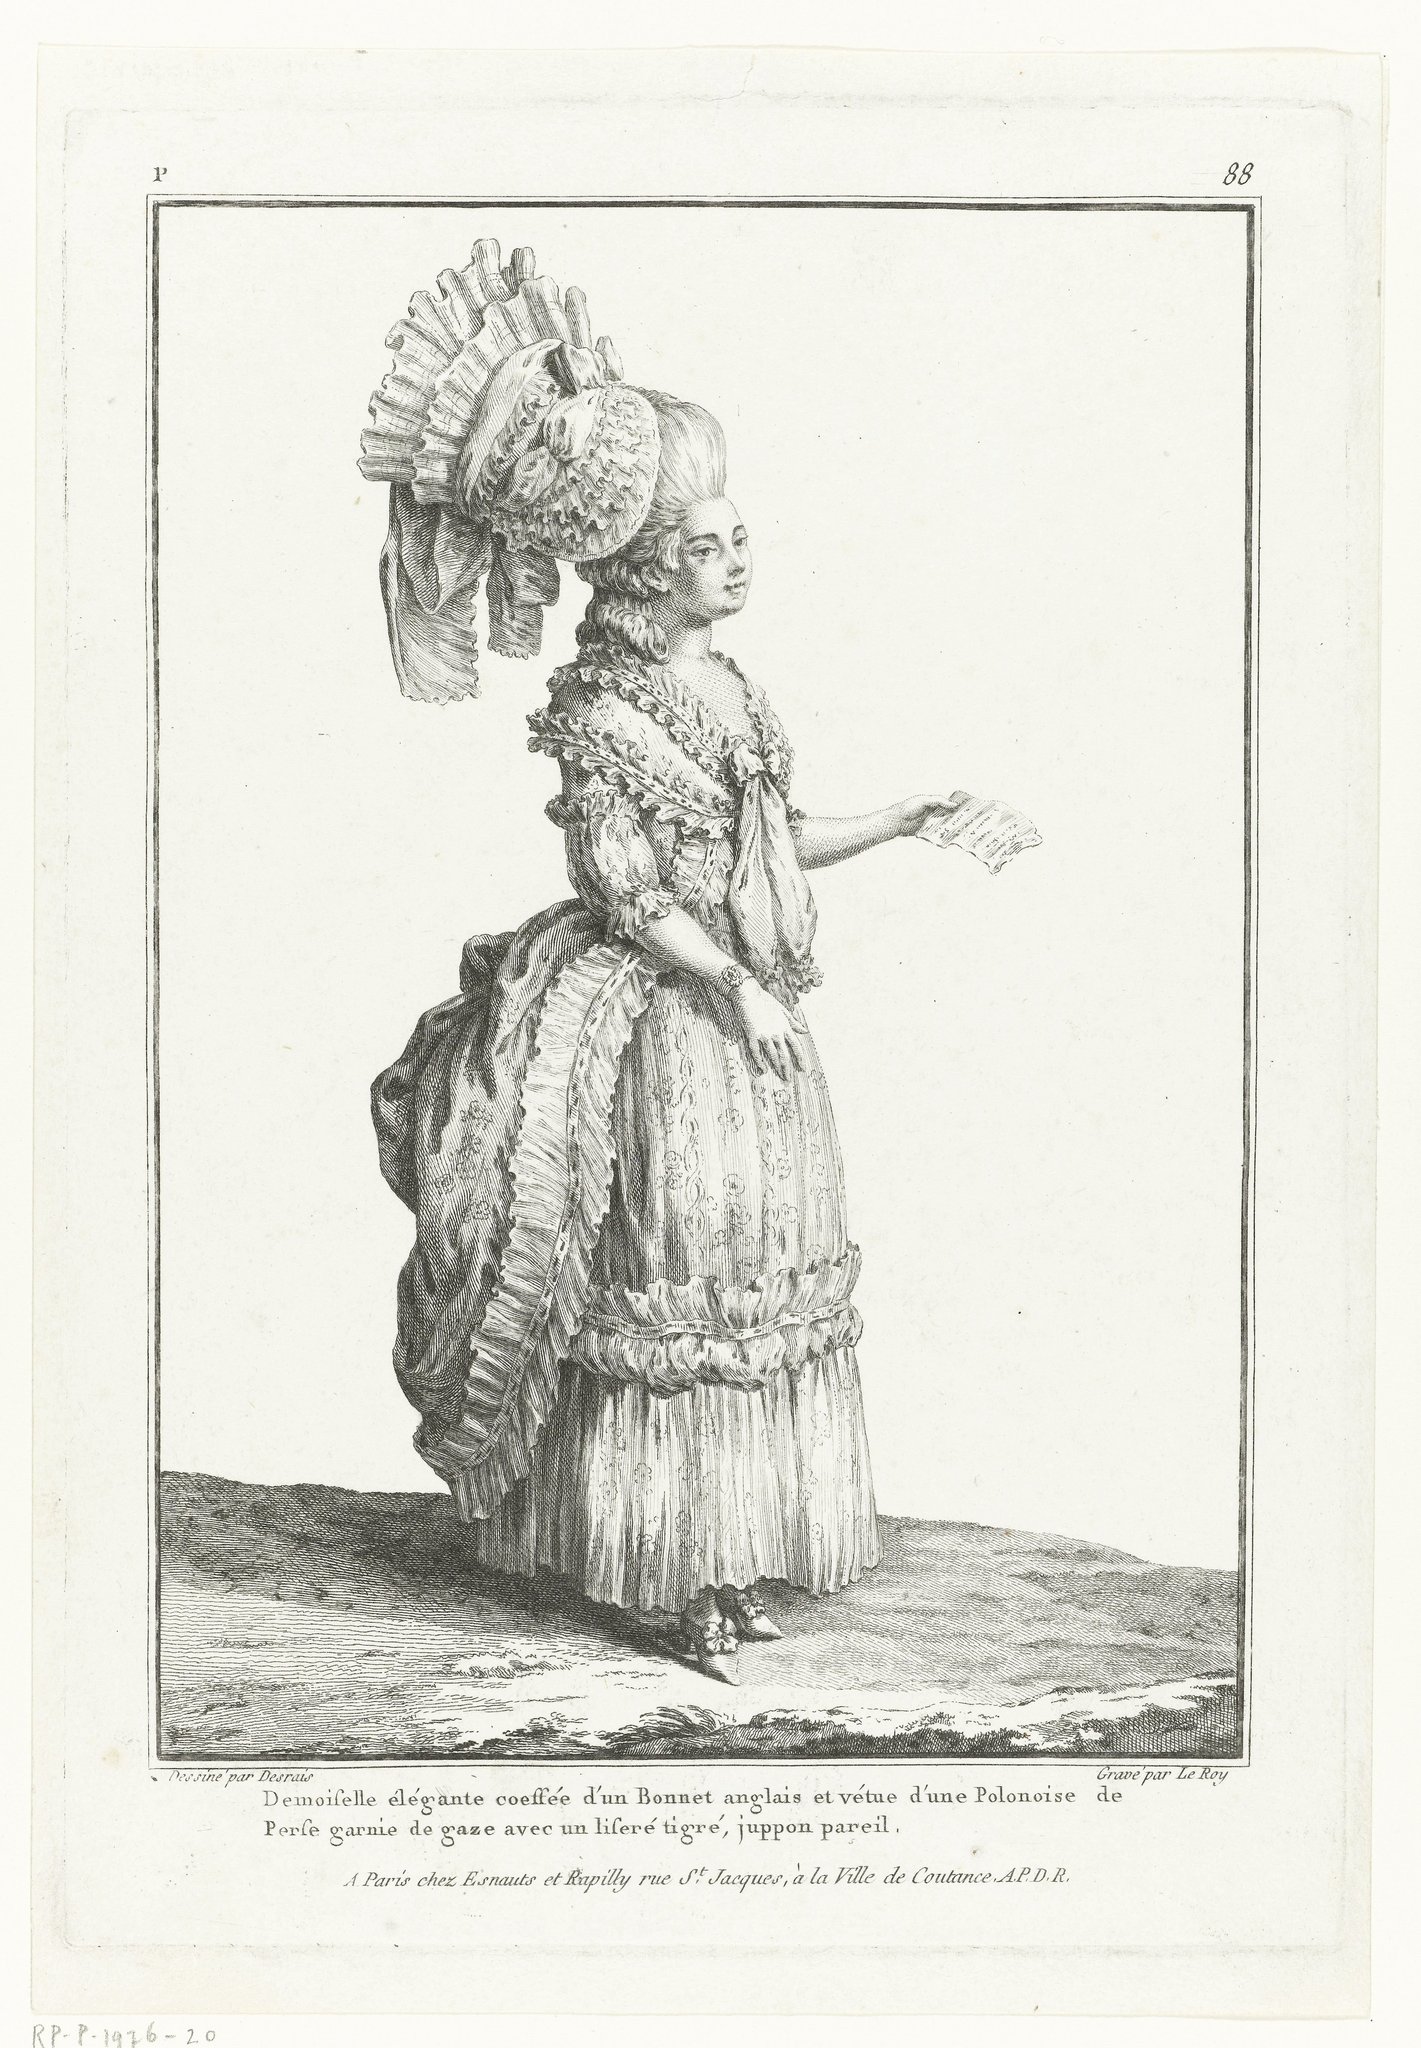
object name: fashion print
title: Gallerie des Modes et Costumes Francais, 1778. P.89: Demoiselle élégante coeffée d'un Bonnet anglais...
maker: julien le roy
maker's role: clockmaker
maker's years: 1686-1759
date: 1778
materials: paper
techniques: etching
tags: styles of hairdress - aa - ~ women, head-gear: cap (+ women's clothes), fashion plates, shoes, sandals (+ women's clothes), skirt (+ women's clothes), letter, envelope, bracelet, wristlet (+ women's clothes), dress, gown: robe à la polonaise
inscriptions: number: ‘88’, serial number: ‘P’, signature: ‘Gravé par Le Roy’, address: ‘A Paris chez Esnauts & Rapilly rue St. Jacques, a la Ville de Coutance. A.P.D.R.’, caption: ‘Demoiselle élégante coeffée anglais et vétue d'une Polonoise de Perse garnie de gaze avec un liseré tigré, juppon pareil.’, signature: ‘Dessiné par Desrais’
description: Elegante ongetrouwde vrouw met een brief in de hand. Zij draagt een 'robe à la Polonaise'. Bijpassende onderrok. Op het hoge kapsel een 'bonnet anglais': een hoge geplooide muts met slippen. Schoenen met hakken en strikken. Prent uit de serie P. 15e Cahier de Costumes Francais, 9e Suite d'Habbilemens à la mode en 1778.